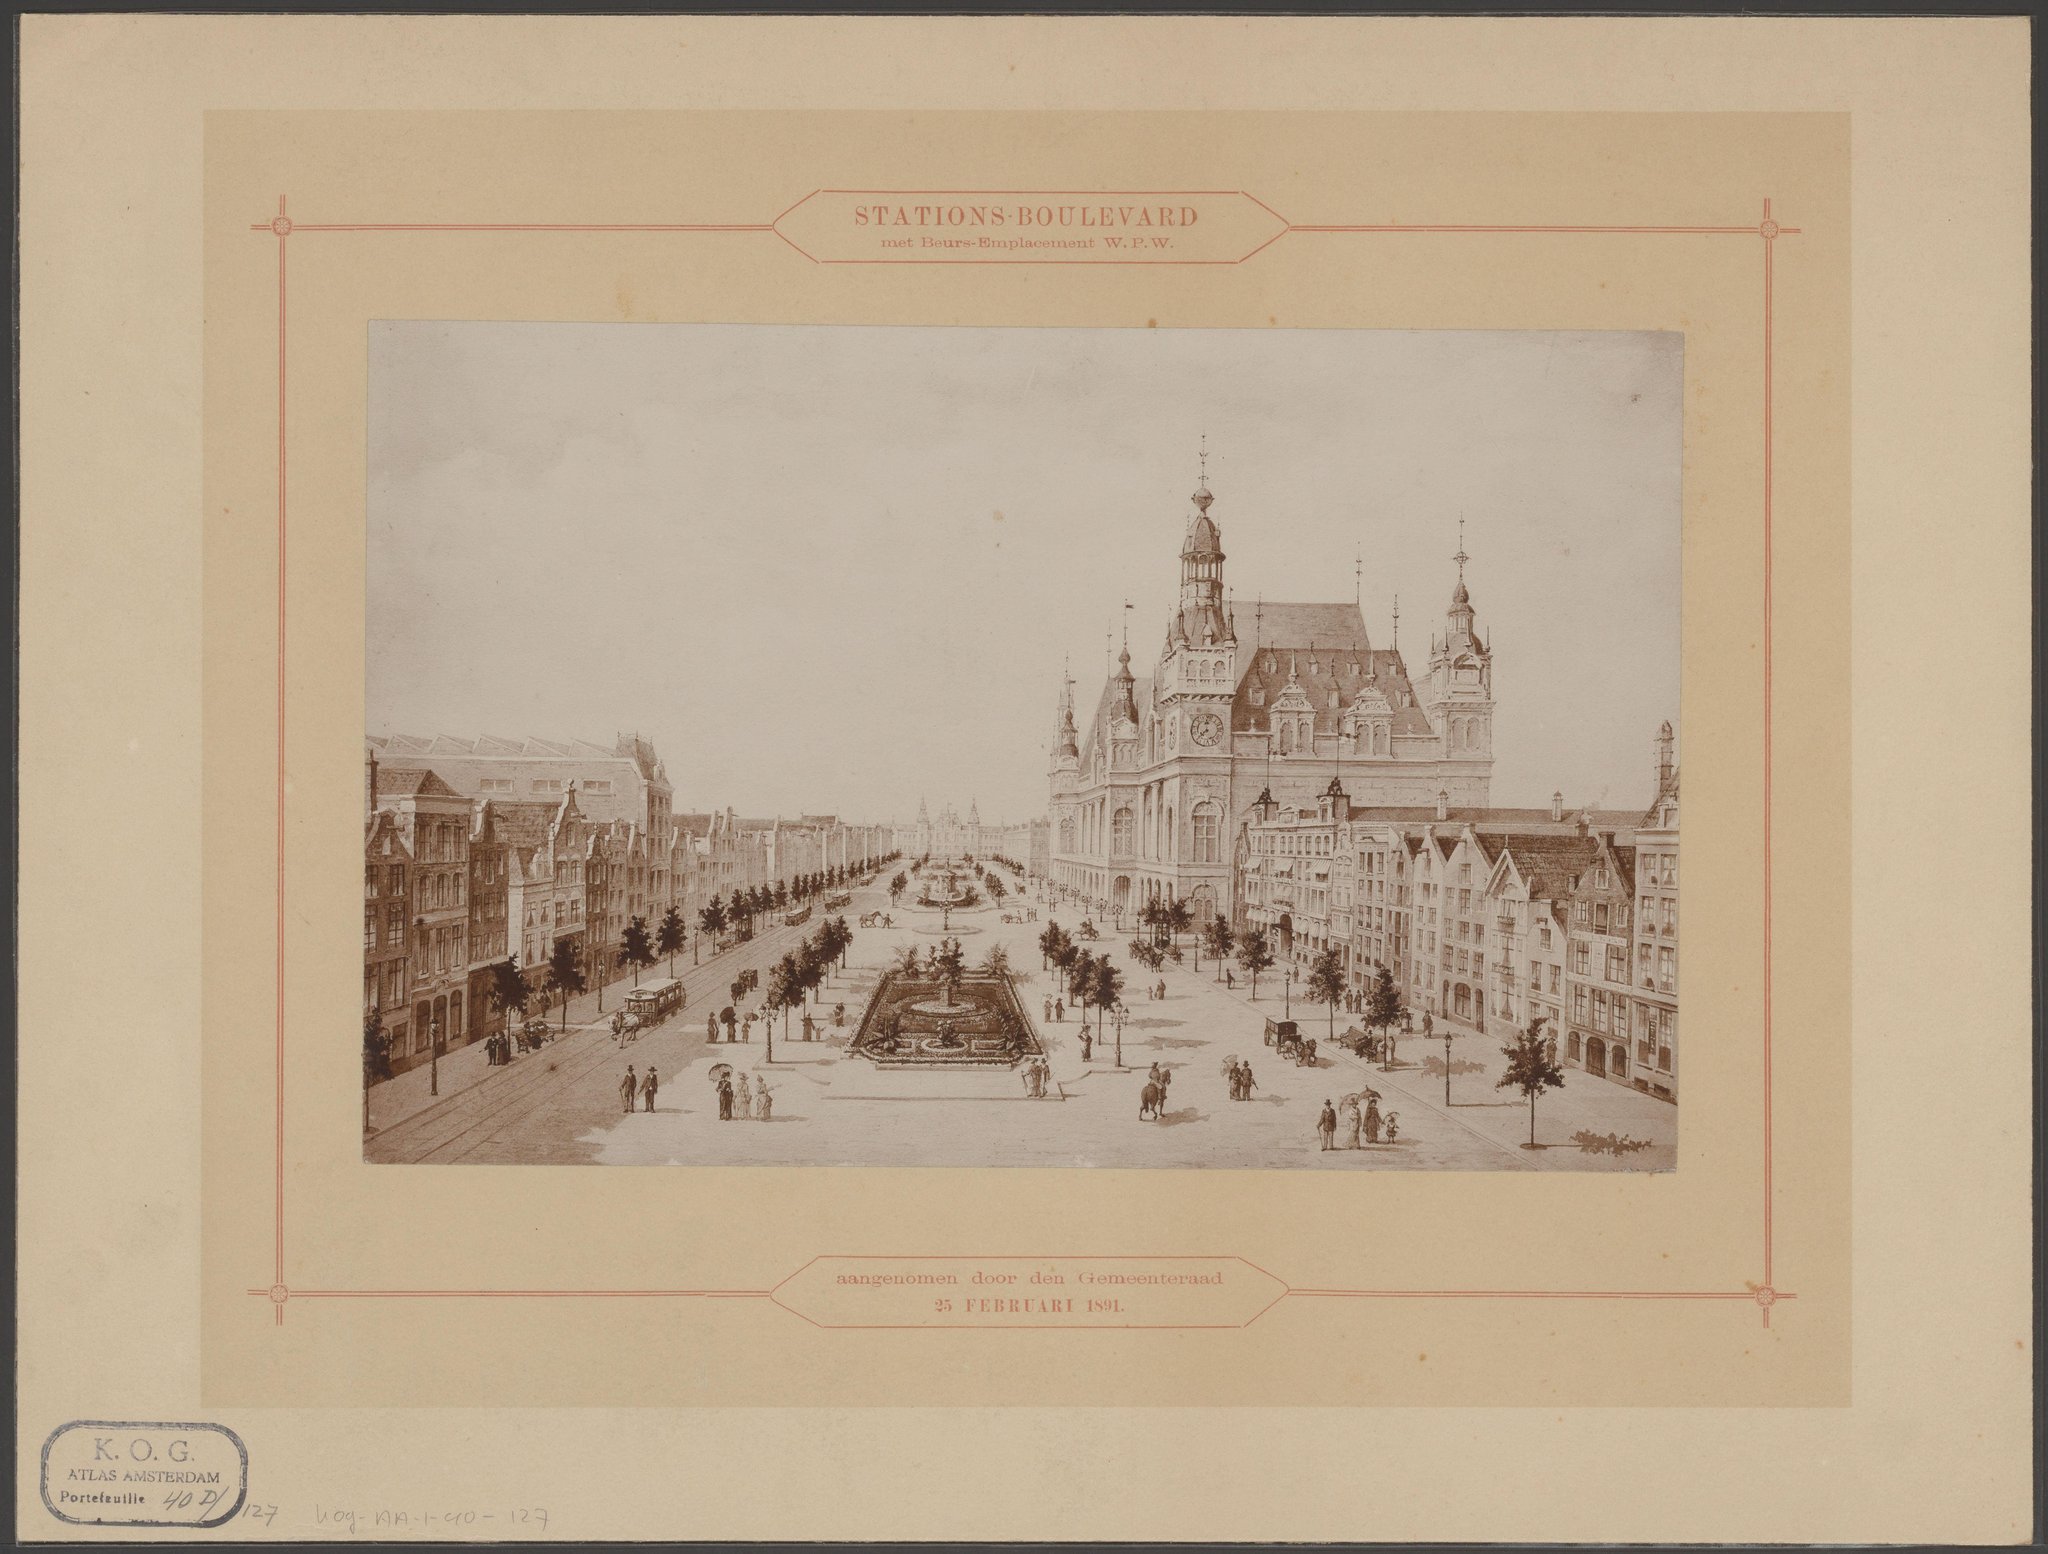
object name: photograph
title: Stations-Boulevard met Beurs-Emplacement W.P.W.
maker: Anonymous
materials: paper, cardboard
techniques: letterpress printing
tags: stock exchange, stock-market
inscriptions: collector's mark: Lugt 1641b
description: Ontwerp voor boulevard en beurs voor Amsterdam, naar het plan van W.P.W. Werker. Onderwerpsrubriek binnen de Atlas Amsterdam: Handel en Zeevaart, D. Beurs-Ontwerpen.